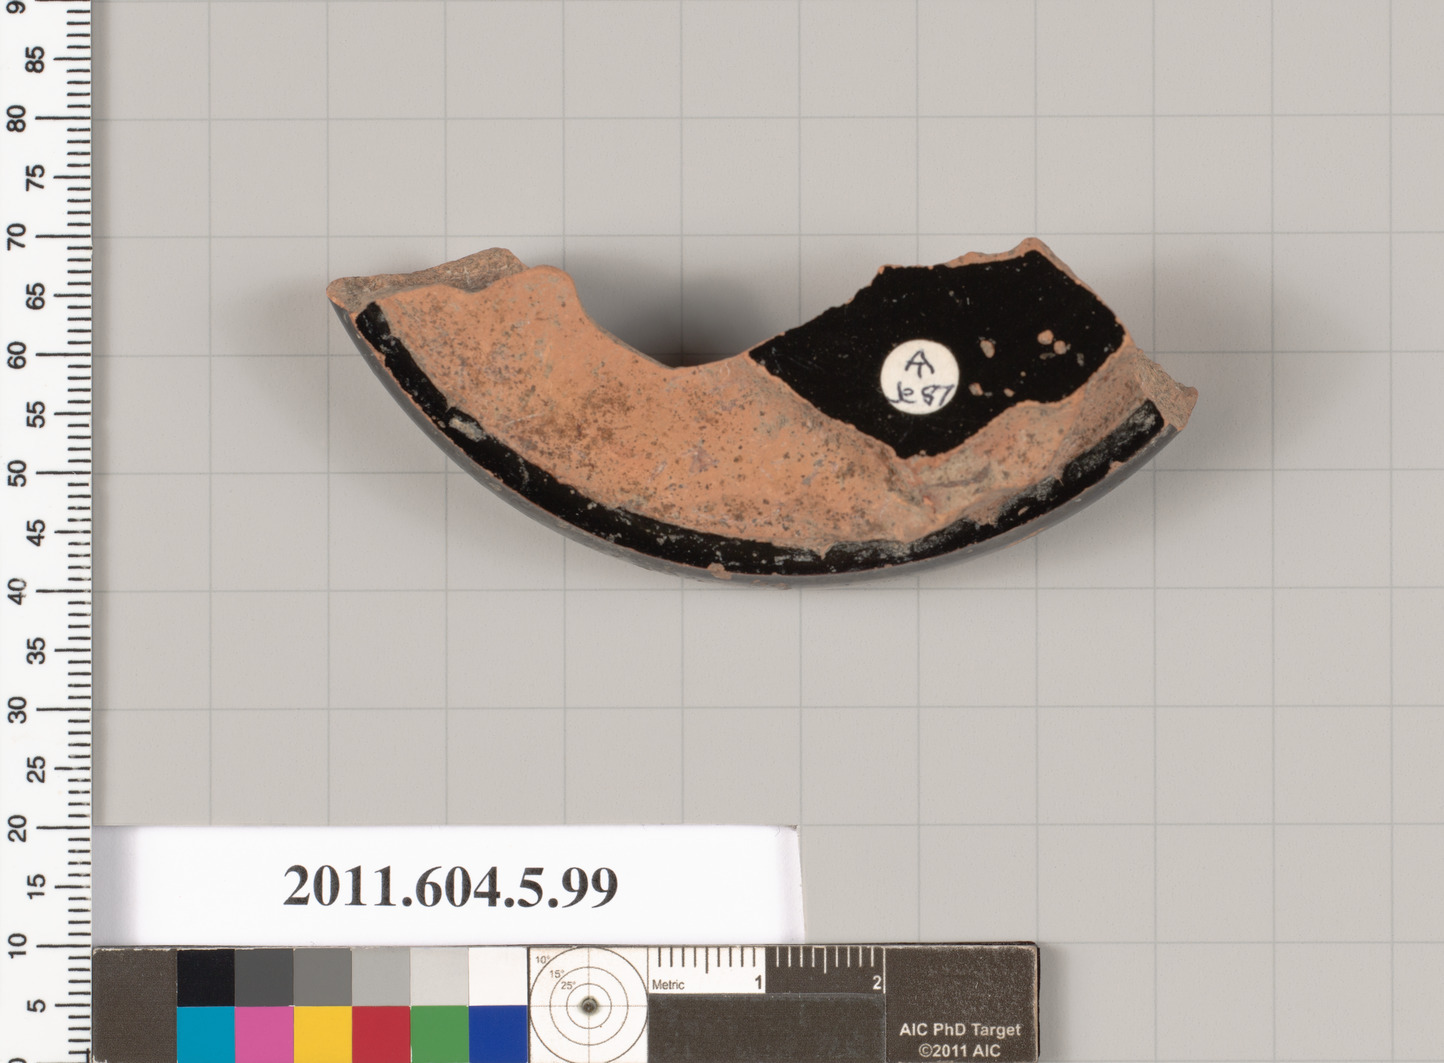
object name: kylix fragment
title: Terracotta fragment of a stemless kylix (drinking cup)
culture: greek, attic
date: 470-450 BCE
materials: terracotta